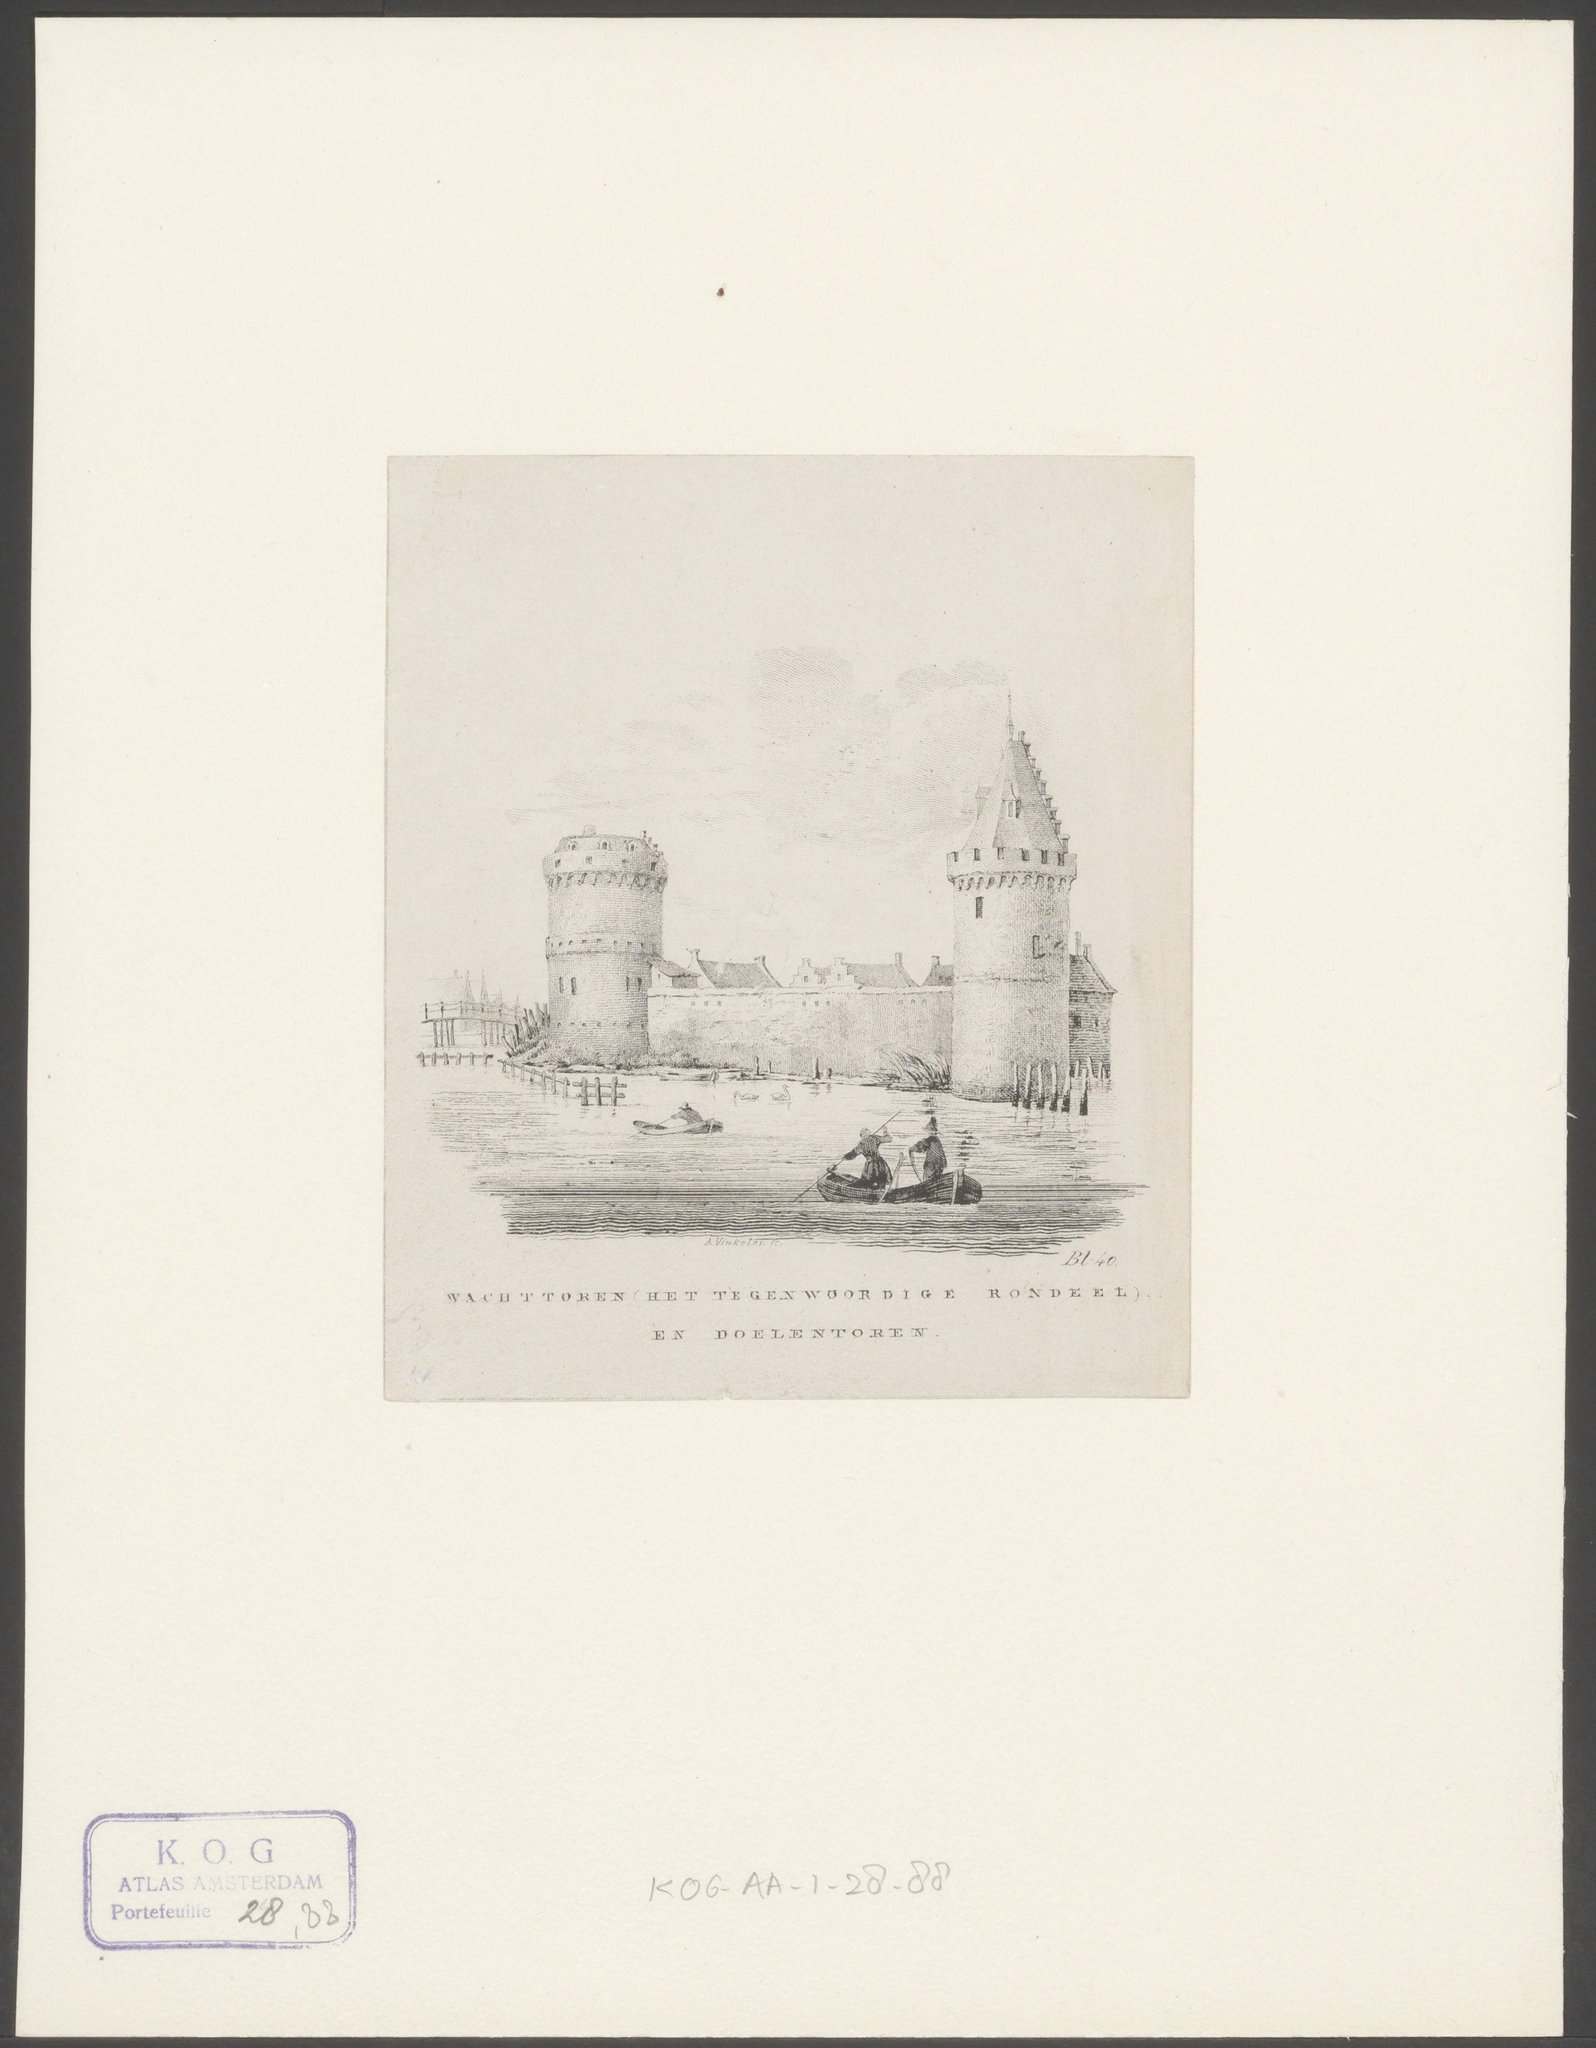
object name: book illustration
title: Gezicht op het Rondeel en de toren Swych Utrecht te Amsterdam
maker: abraham vinkeles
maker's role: draughtsman, print maker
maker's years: 1790-1864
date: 1844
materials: paper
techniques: etching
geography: amsterdam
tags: towers ~ fortified city, rowing-boat, canoe, etc.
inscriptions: collector's mark: Lugt 1641b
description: Rechtsonder: Bl. 40. Onderwerpsrubriek binnen de Atlas Amsterdam: Vestingwerken: Bolwerken - Rondeel - Wachttorens - Blokhuizen - Kazematten - Ontwerpen Kostuum Alva.